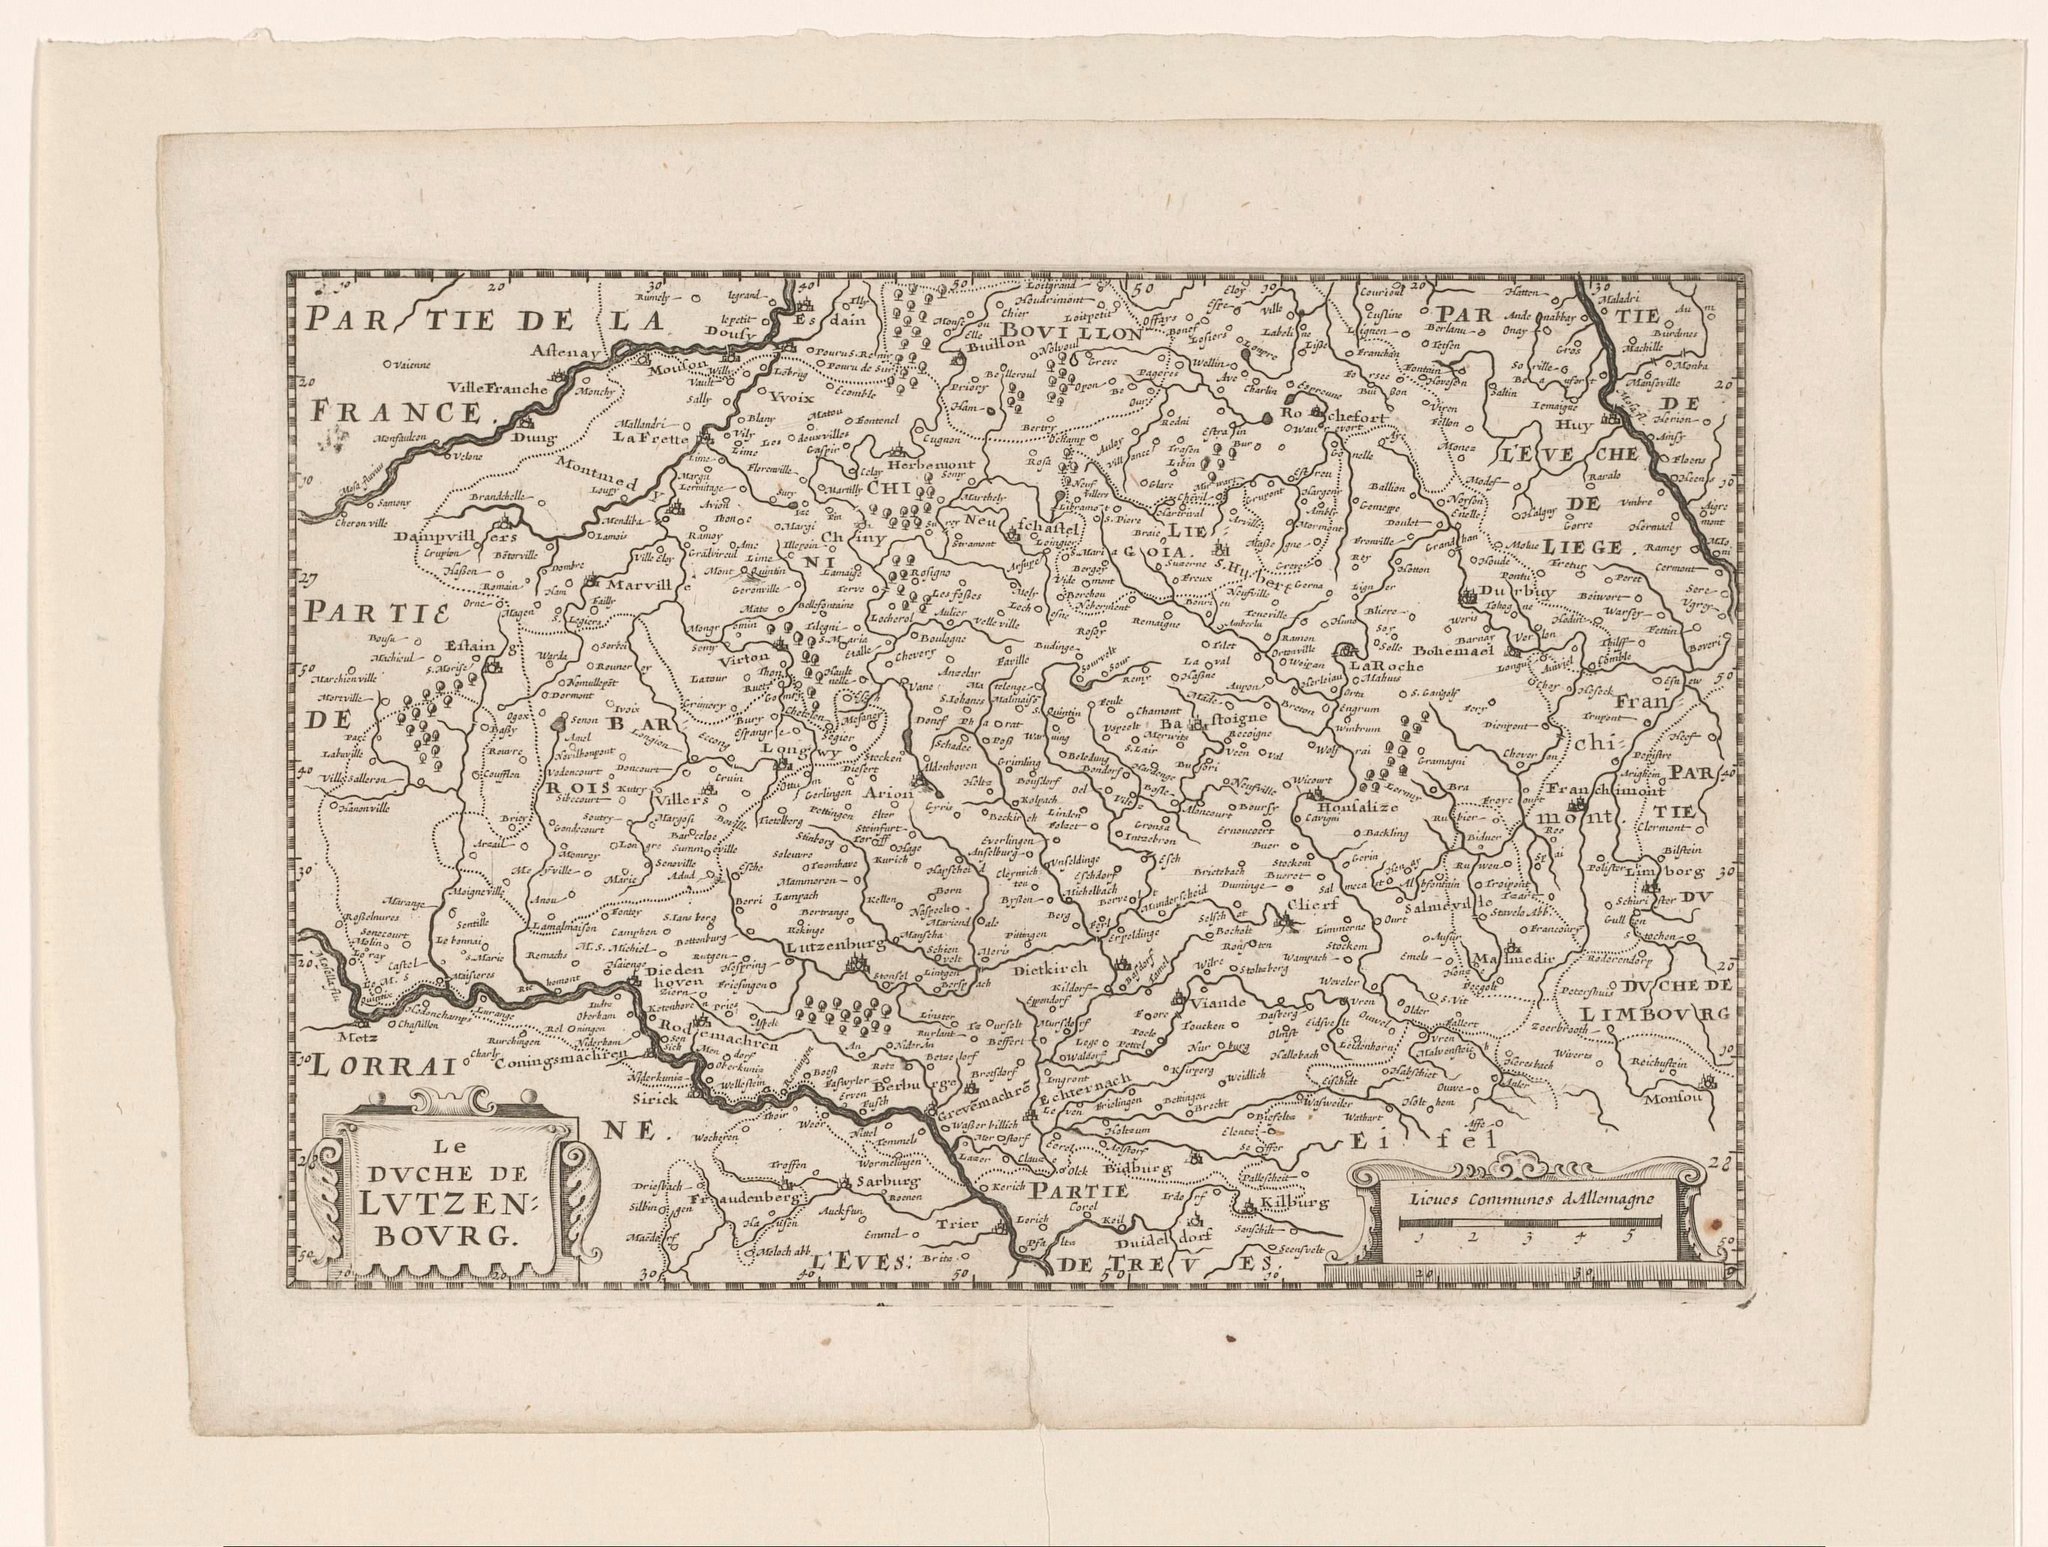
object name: print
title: Le duche de Lutzenbourg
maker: Anonymous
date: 1635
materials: paper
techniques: engraving, etching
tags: maps of separate countries or regions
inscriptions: collector's mark: Lugt 2228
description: Deze staat van prent ook gebruikt in: De vyerighe colom klaer vertoonende in vyftich onderscheydene curieuse caarten de XVII. Nederlantsche Provincien (…). Amsterdam: Jacob Aertsz Colom (I), s.a. [ca. 1660]. En in latere uitgaven met de platen van deze publicatie, uitgegeven door Pieter van Alphen (1691) en Pieter van der Slaart (1696). Eerdere staat van prent (zonder '9' rechtsonder) ook gebruikt in eerdere drukken van deze publicatie.